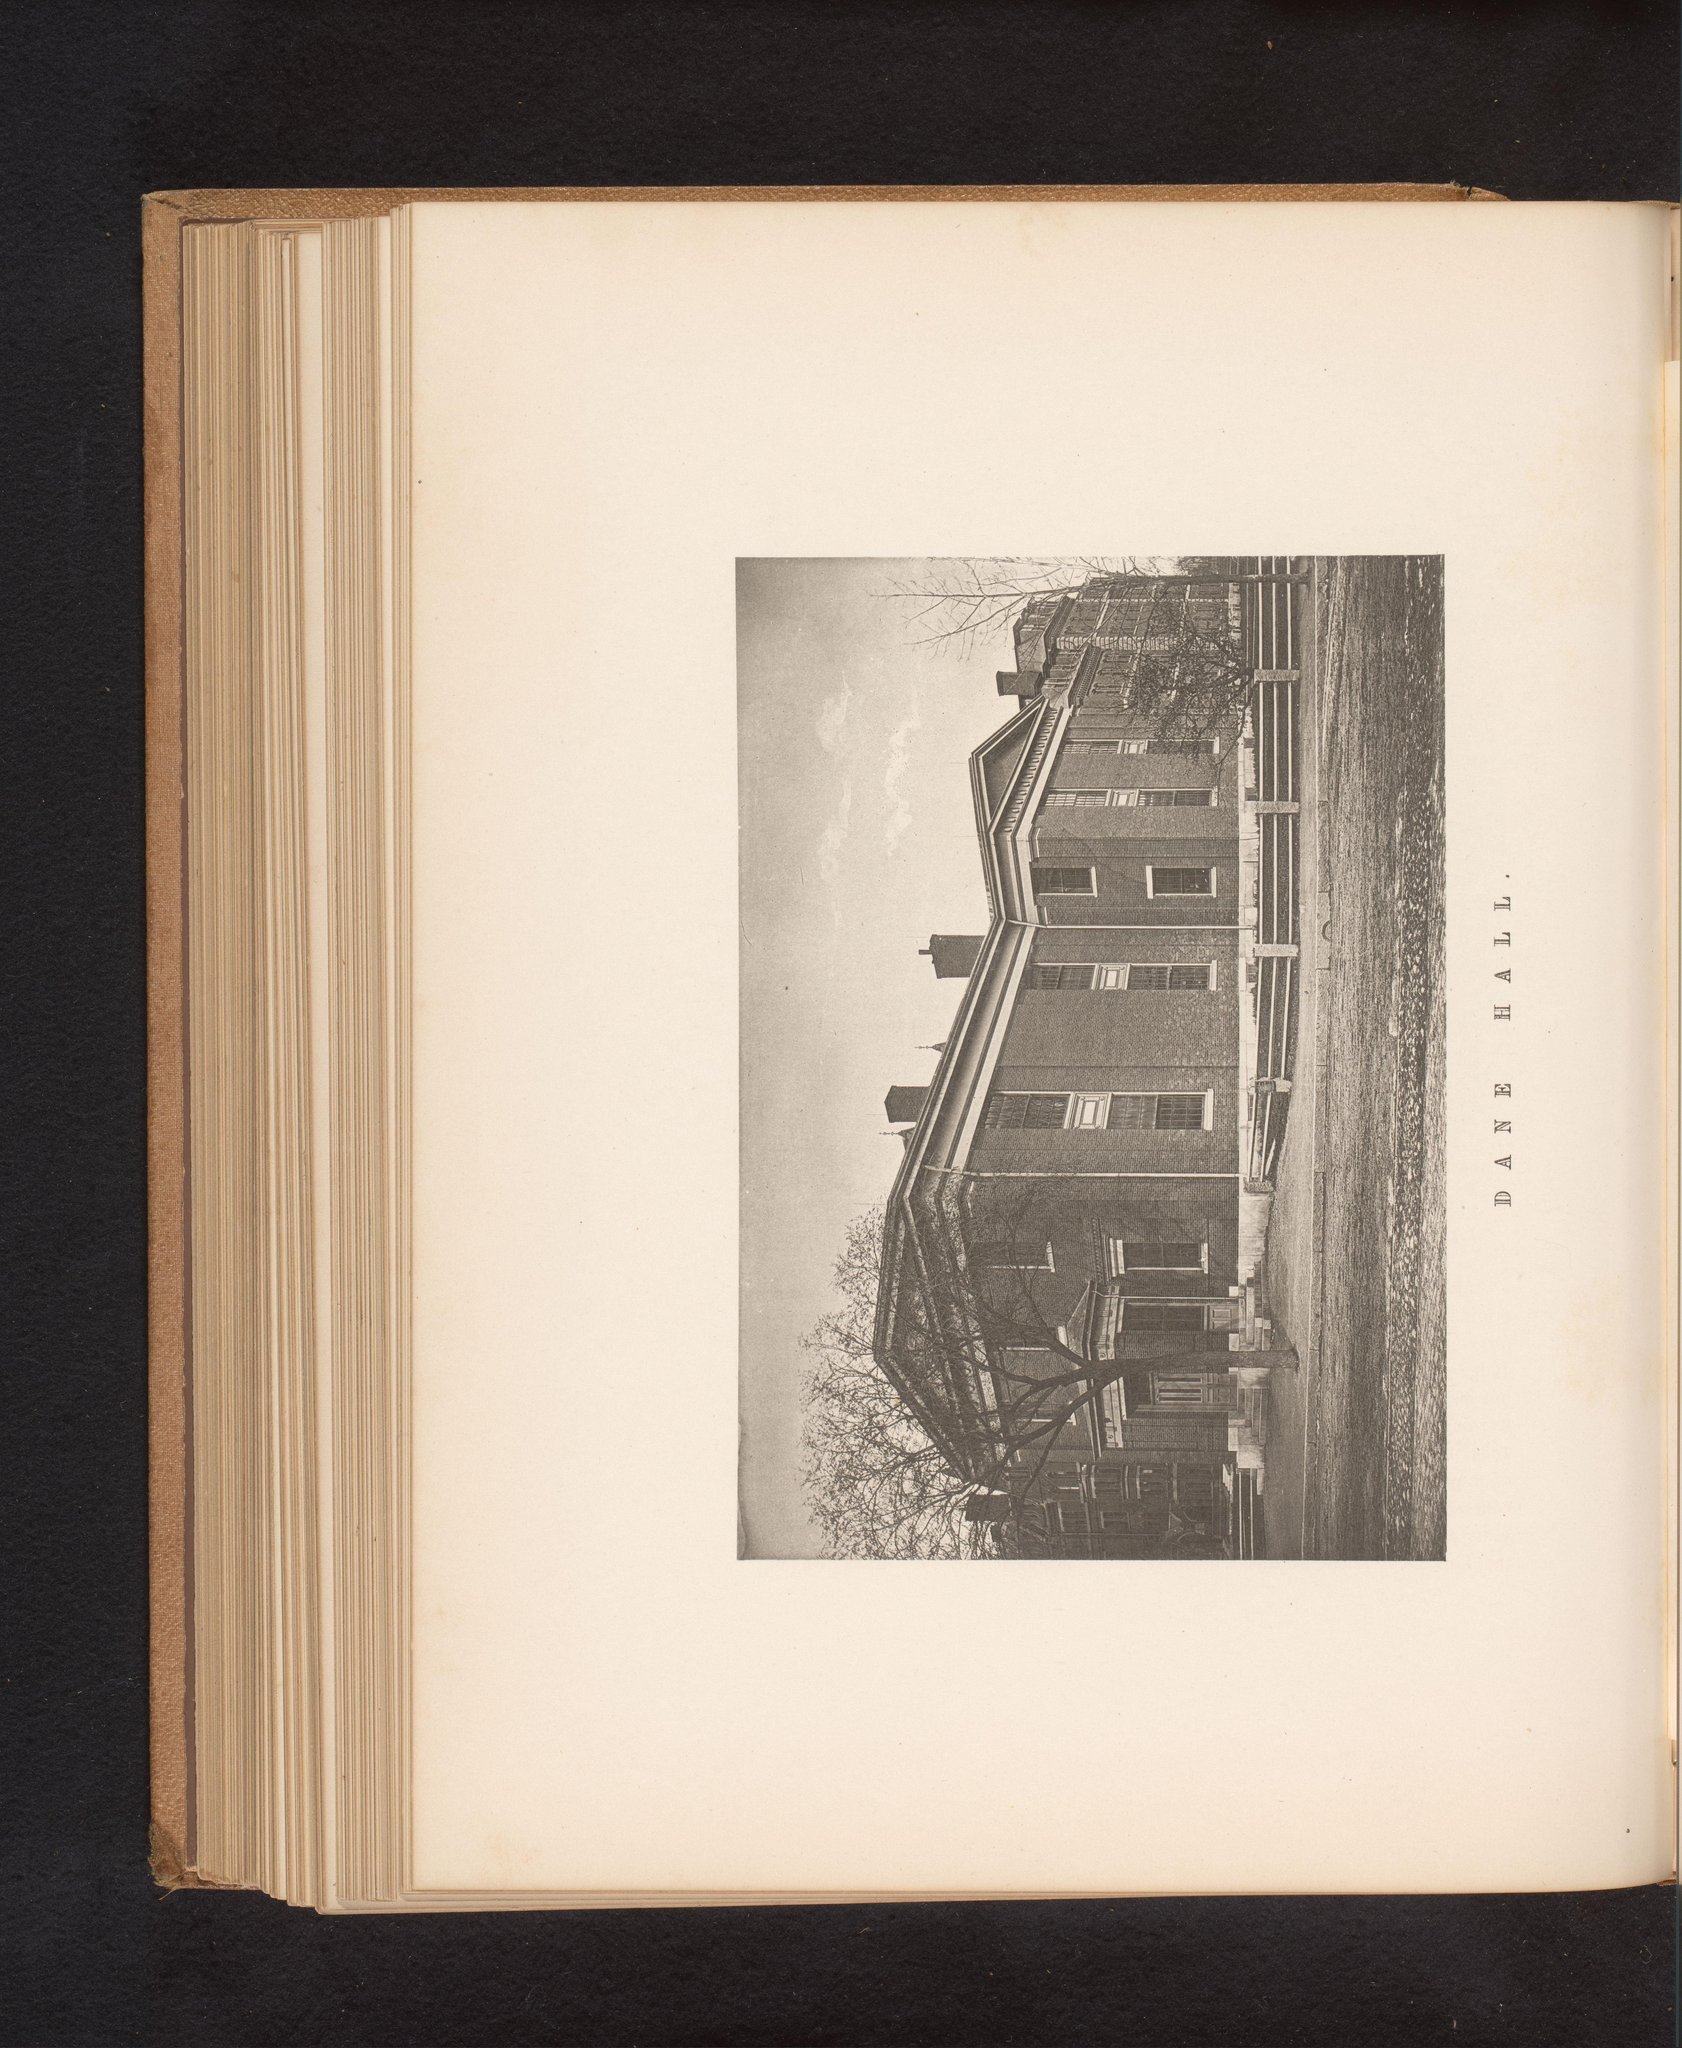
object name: page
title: Gezicht op Dane Hall van de Harvard-universiteit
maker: Anonymous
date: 1870-1875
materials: paper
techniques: photograph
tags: university building, college